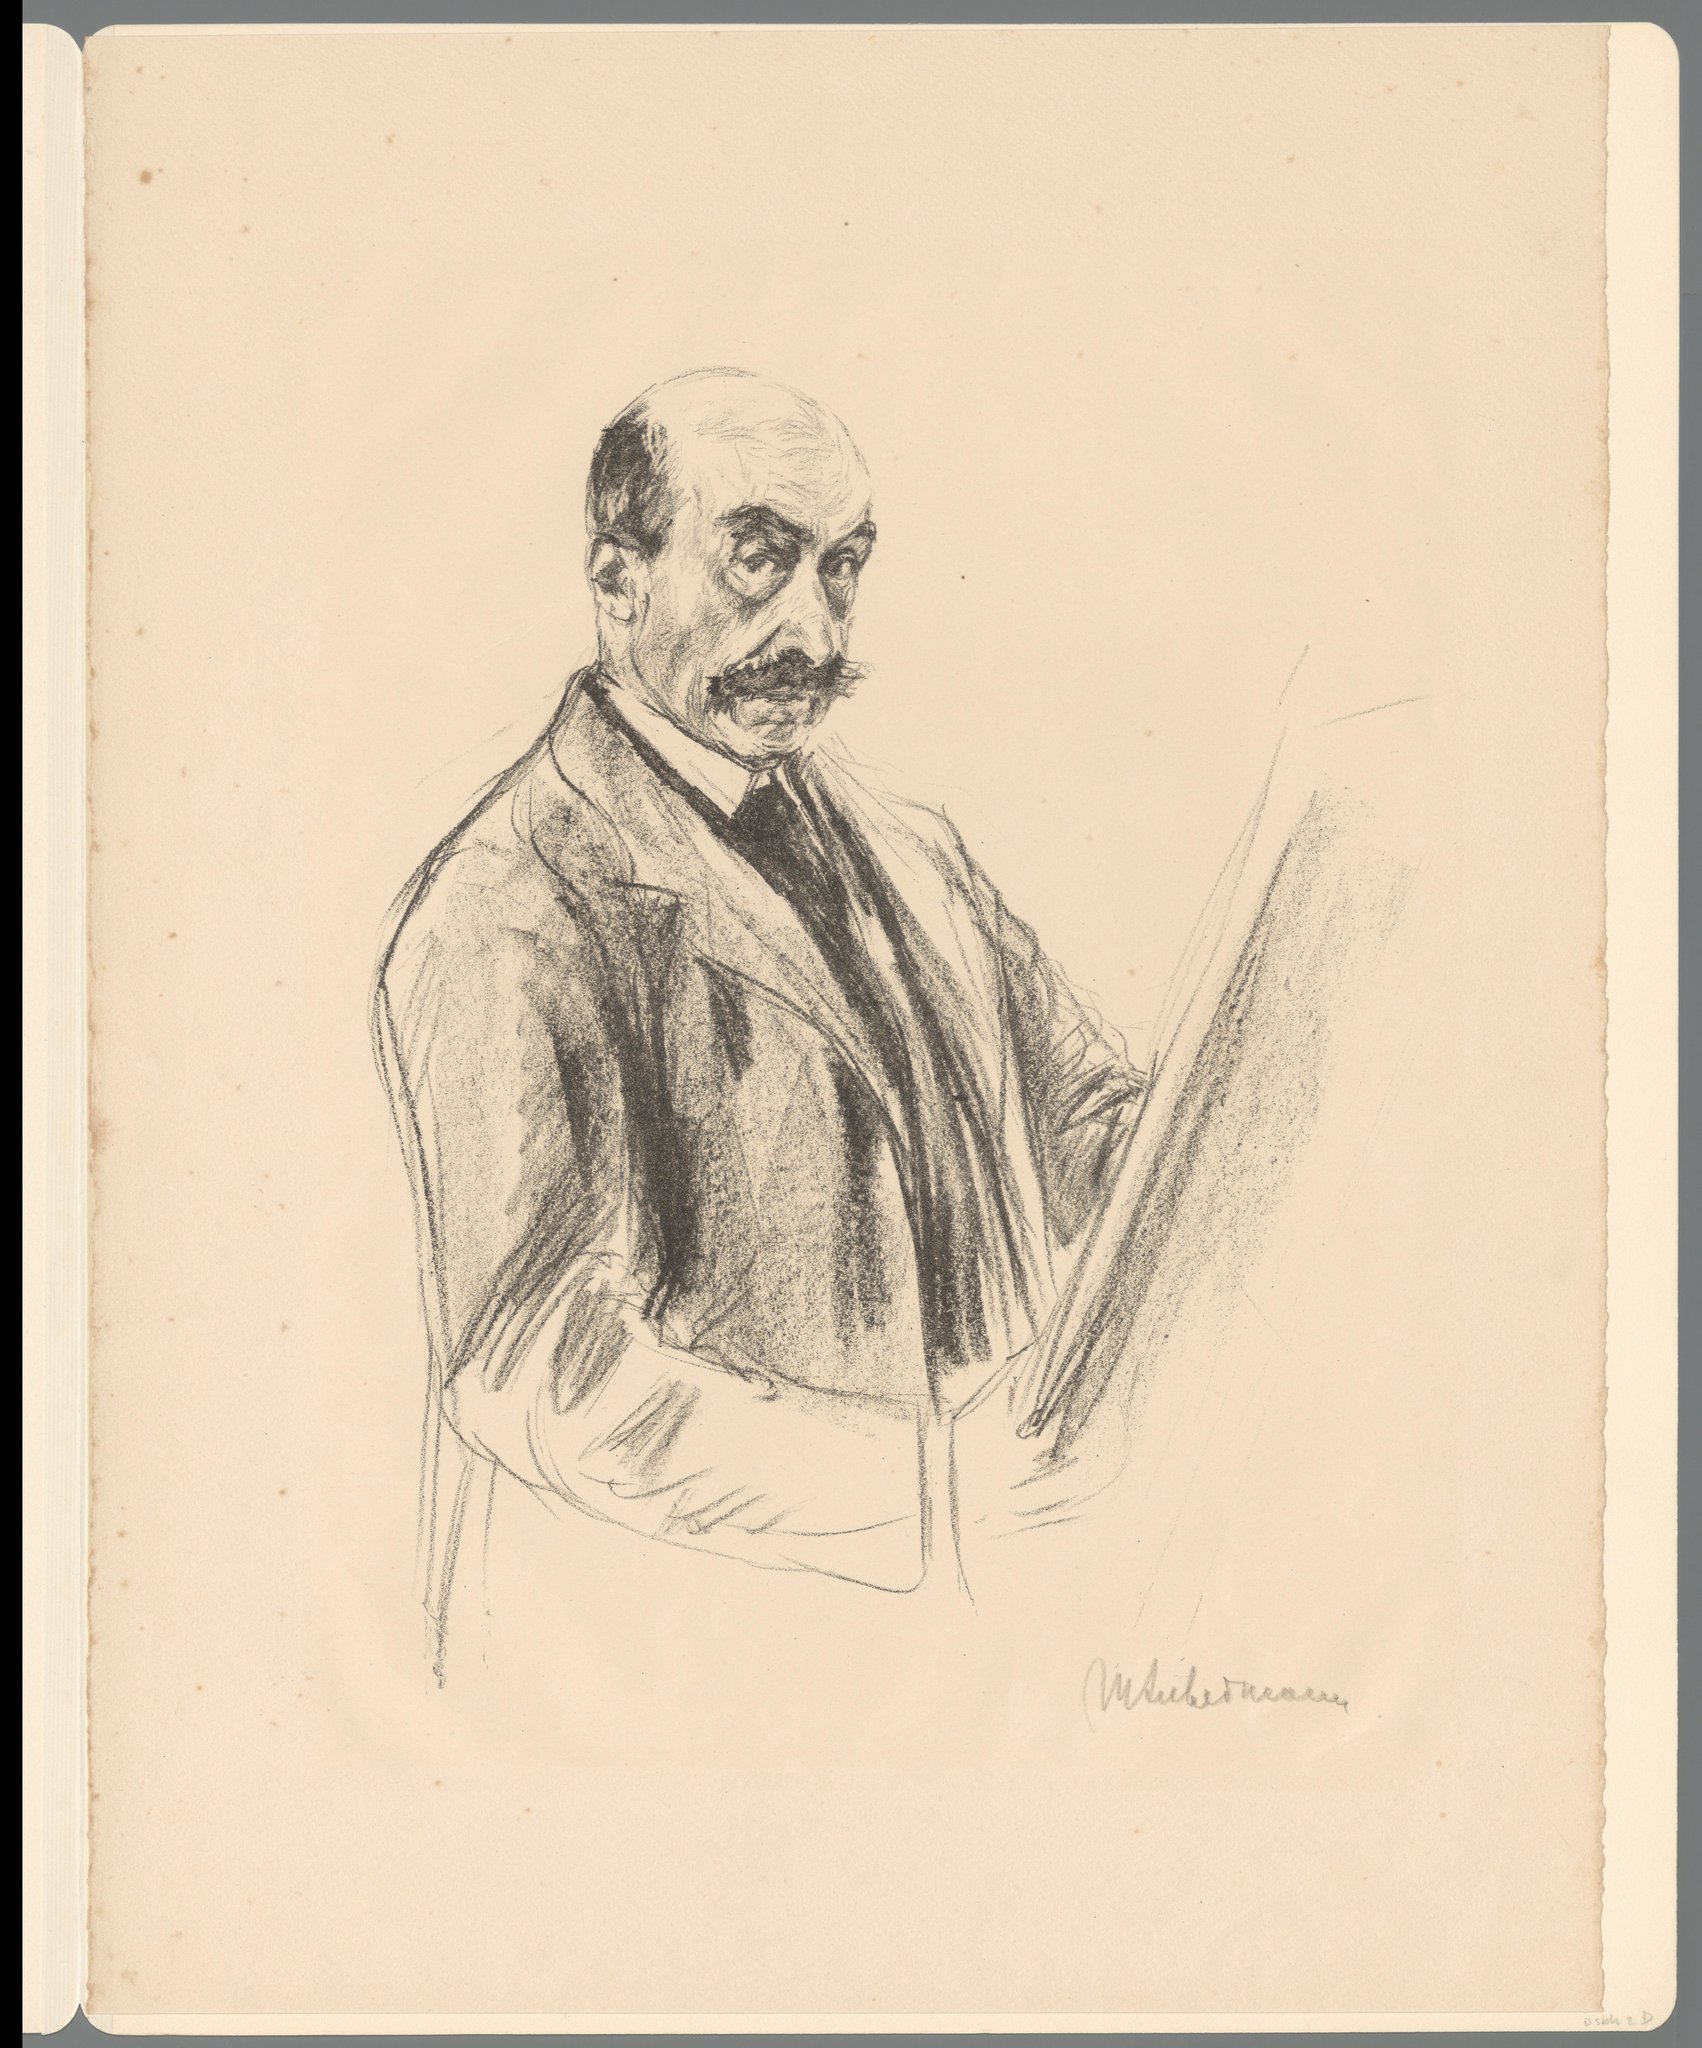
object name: print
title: Zelfportret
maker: max liebermann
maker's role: draughtsman, print maker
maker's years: 1847-1935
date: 1900-1935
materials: paper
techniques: lithograph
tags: berlin, print maker, draughtsman, max liebermann, historical persons, portrait, self-portrait of painter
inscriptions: collector's mark: Lugt 2228